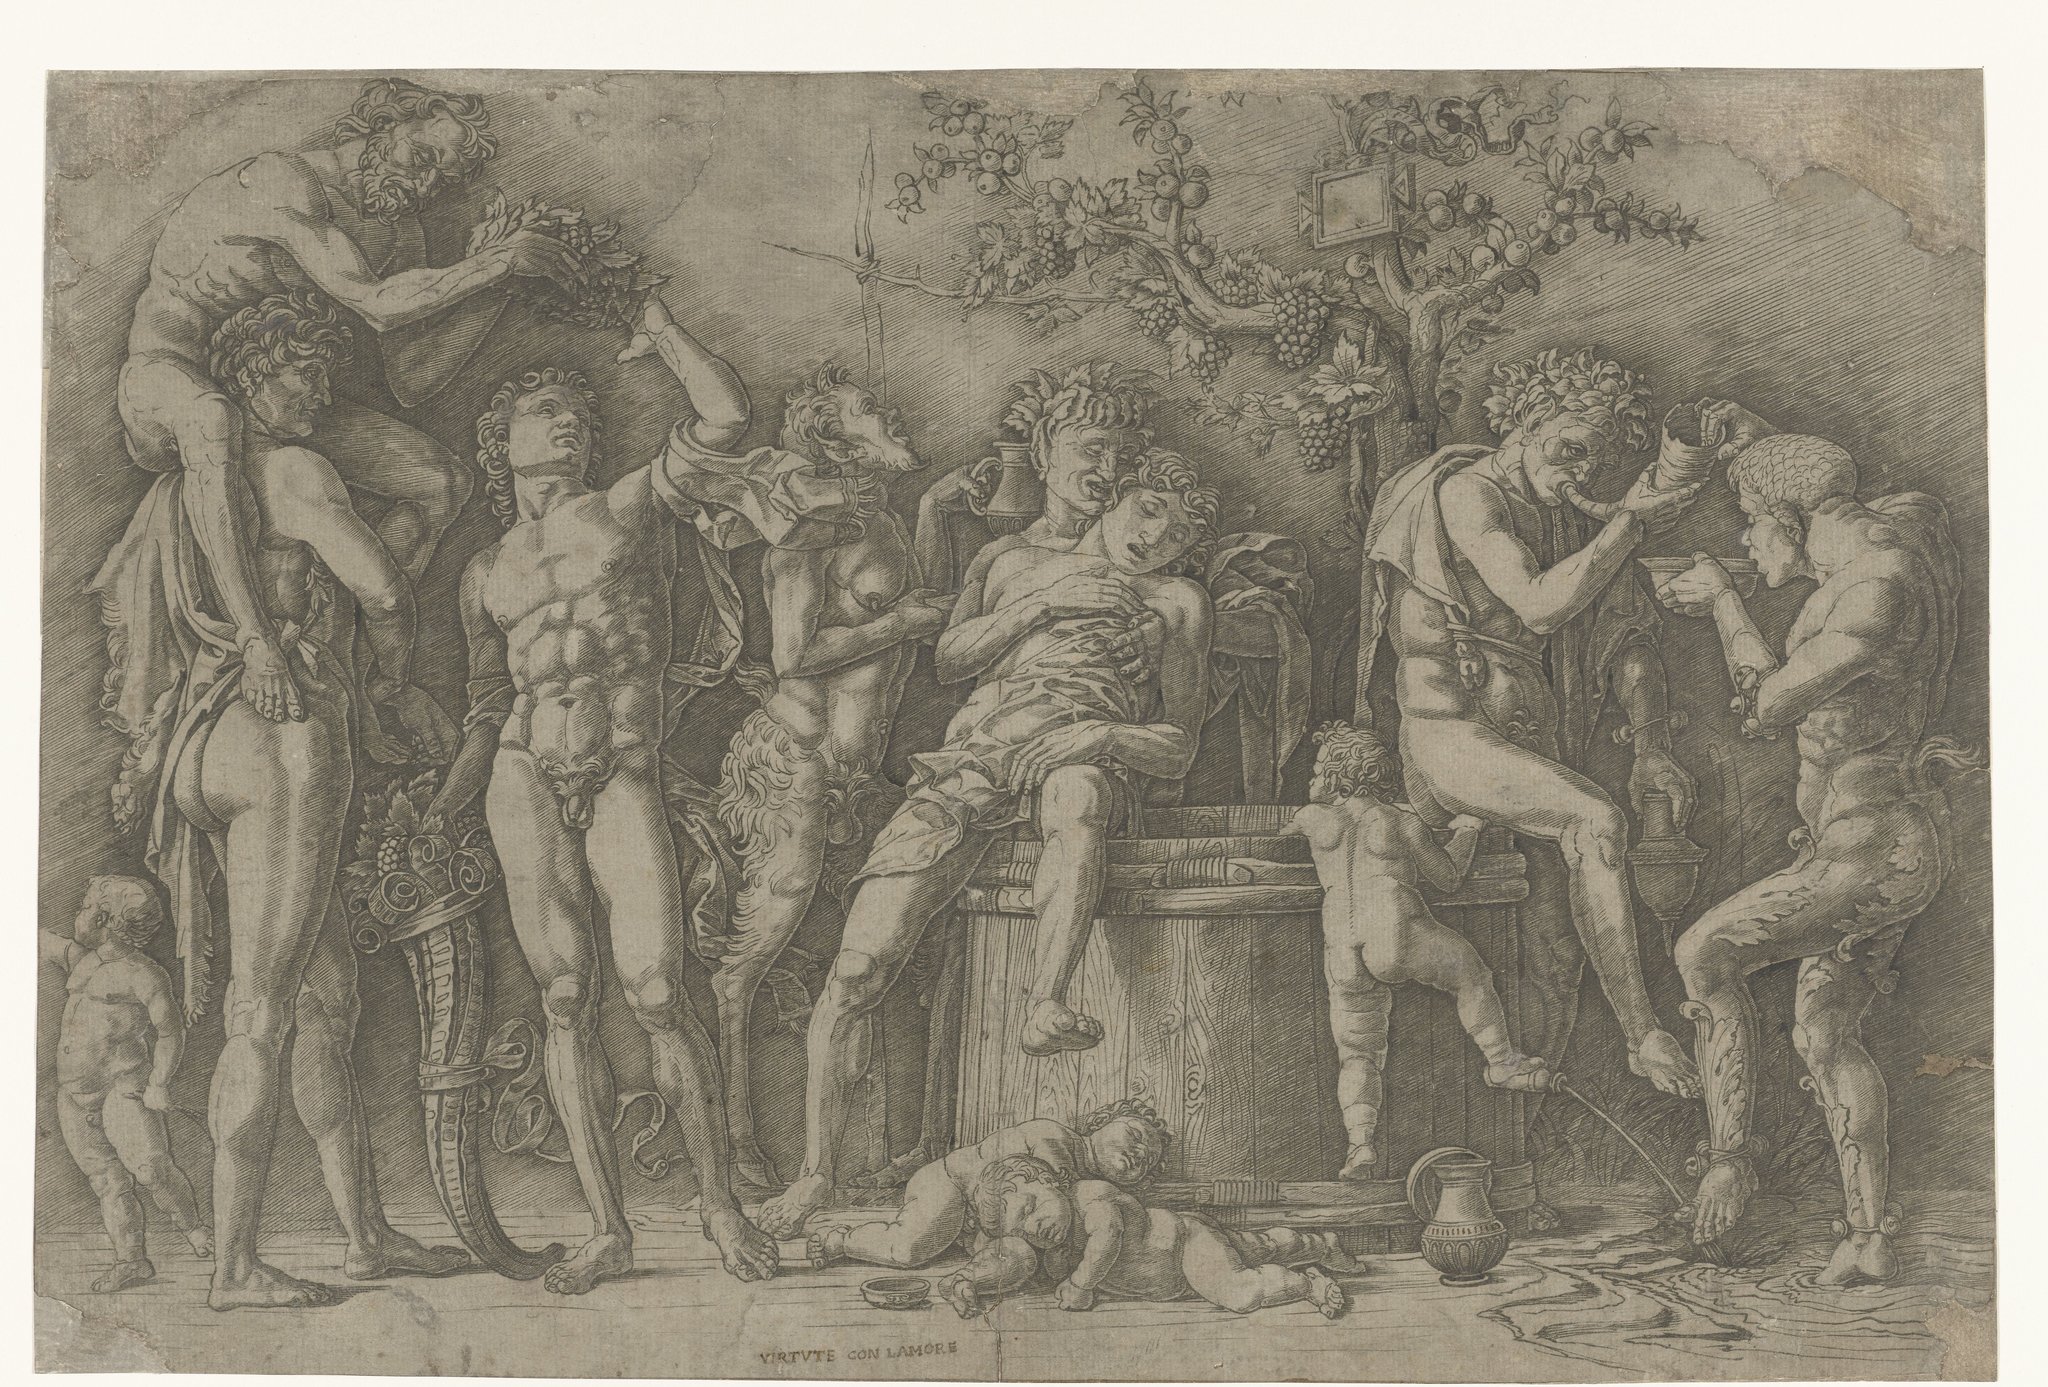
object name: print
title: Bacchanaal met satyrs en bacchanten bij wijnpers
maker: andrea mantegna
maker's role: print maker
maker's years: 1431-1506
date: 1473-1477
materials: paper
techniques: engraving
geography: italy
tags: thiasos, i.e. bacchus' revel-rout, bacchanal without bacchus, wine-press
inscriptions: collector's mark: Lugt 2228, inscription: ‘VIRTVTE CON LAMORE’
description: Ontbrekende stukken alle vier hoeken en bovenrand van prent zijn aangevuld.